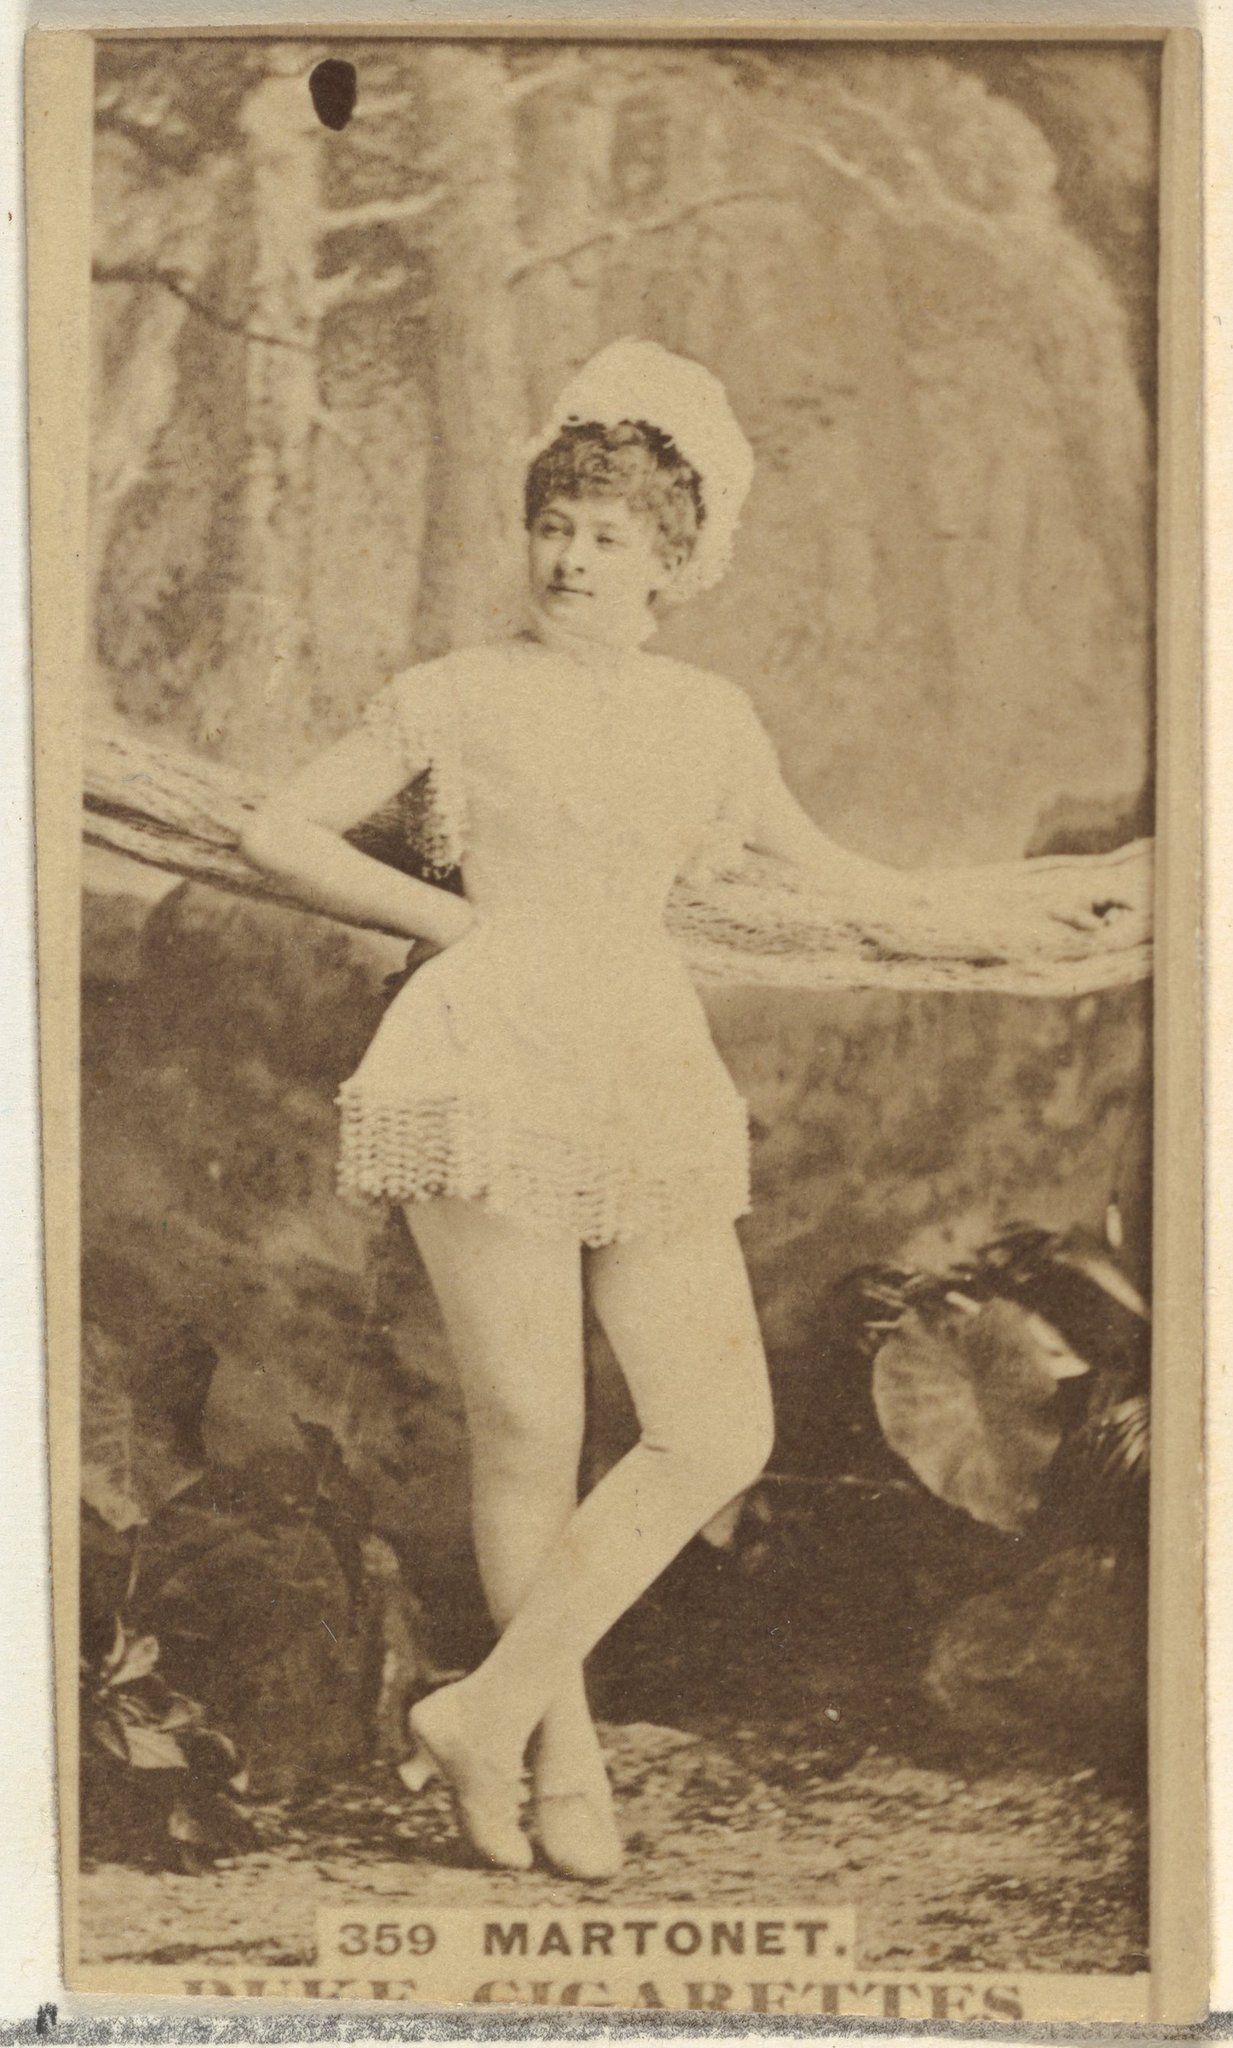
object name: photograph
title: Card Number 359, Martonet, from the Actors and Actresses series (N145-7) issued by Duke Sons & Co. to promote Duke Cigarettes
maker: w. duke, sons & co.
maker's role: publisher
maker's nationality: american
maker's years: 1870-1920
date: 1880-1889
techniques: albumen silver print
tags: portraits,women,actresses